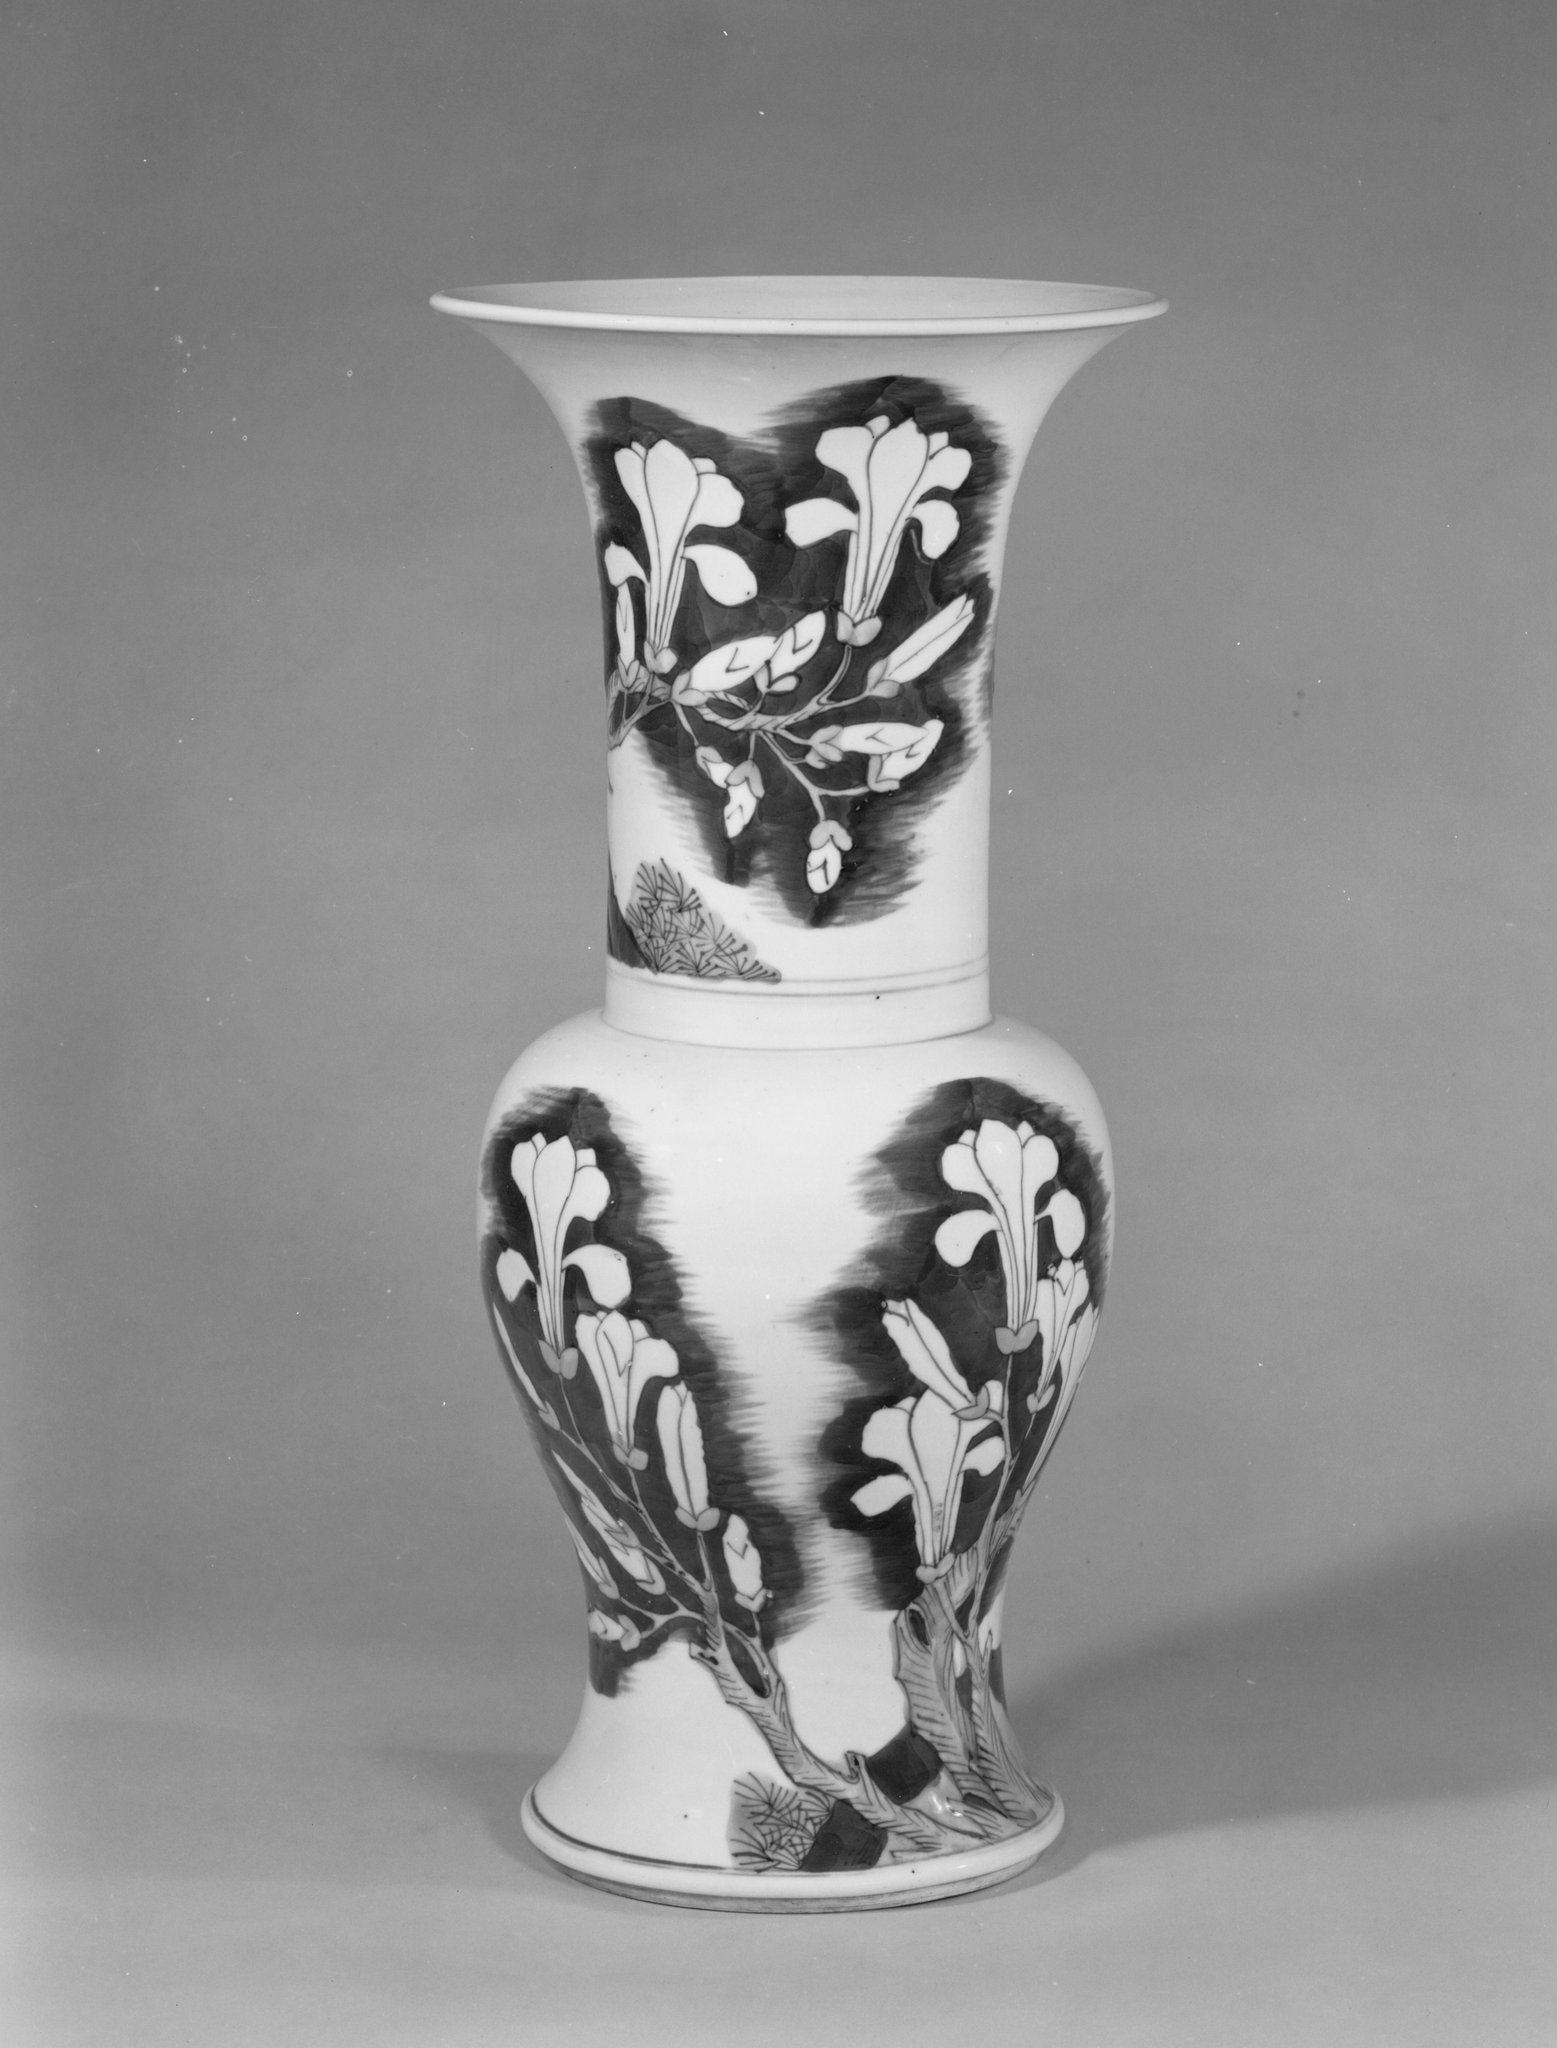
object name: vase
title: Vase with Magnolias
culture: chinese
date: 1667-1700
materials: cobalt, glaze, porcelain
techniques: painting, relief